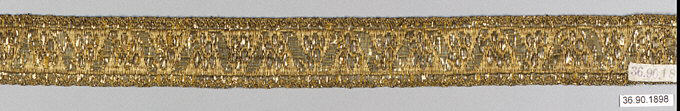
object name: galloon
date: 1767-1833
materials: metal thread, silk